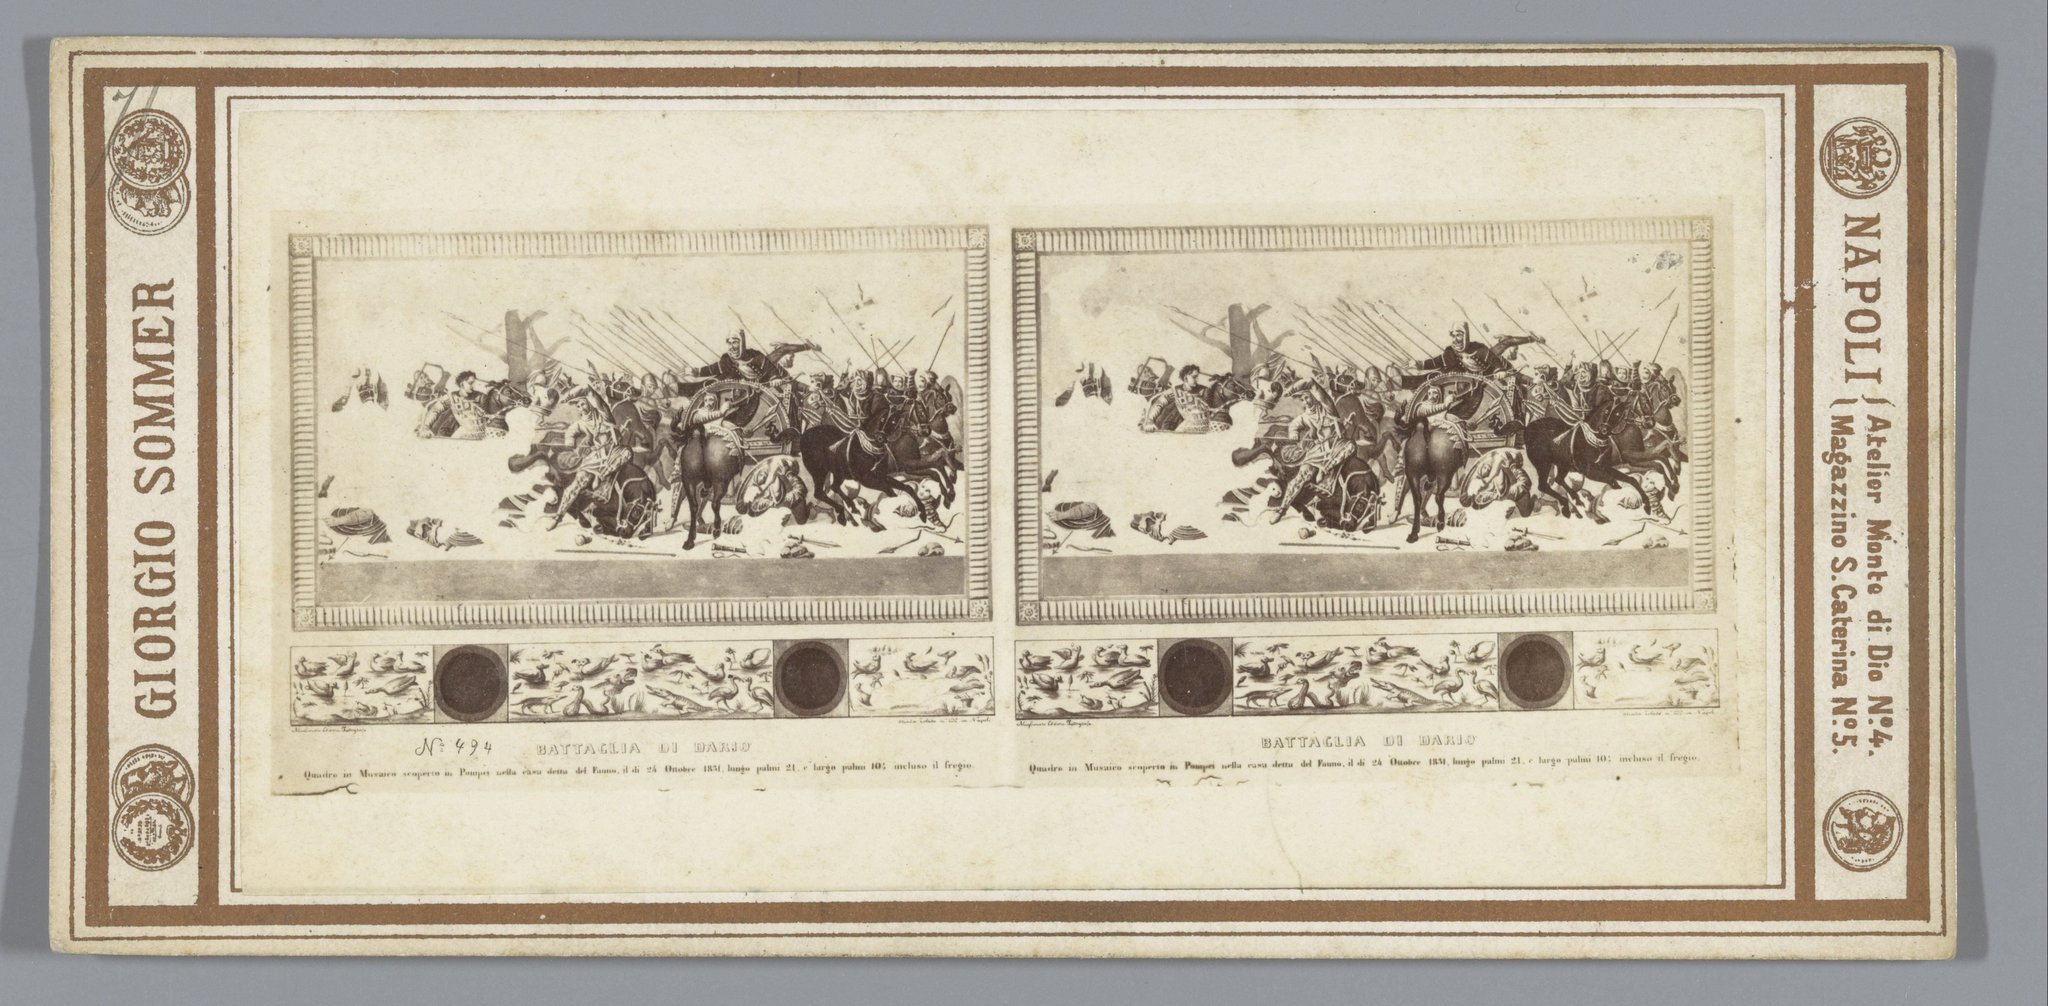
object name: reproduction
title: Battaglia di Dario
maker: giorgio sommer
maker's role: fotograaf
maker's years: 1834-1914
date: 1860-1880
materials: cardboard, photographic support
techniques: albumen print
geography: naples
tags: floor-covering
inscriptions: inscription: ‘Gevecht van Darius Mozaiek vloer uit het huis van Faun Pompeii’, number: ‘No 494’